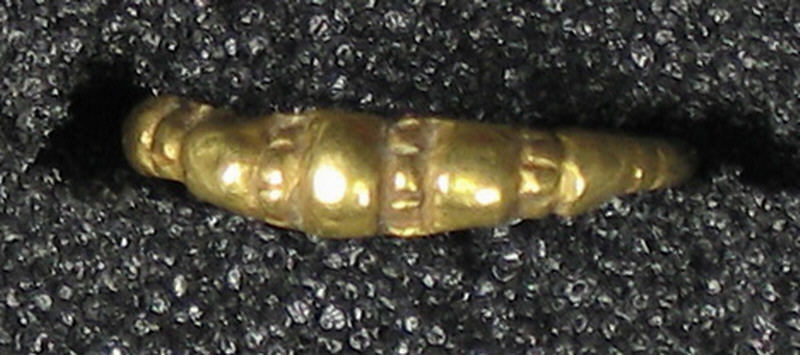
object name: ring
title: Ring Cast, Incised, and Notched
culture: indonesian, central java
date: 701-1200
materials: gold